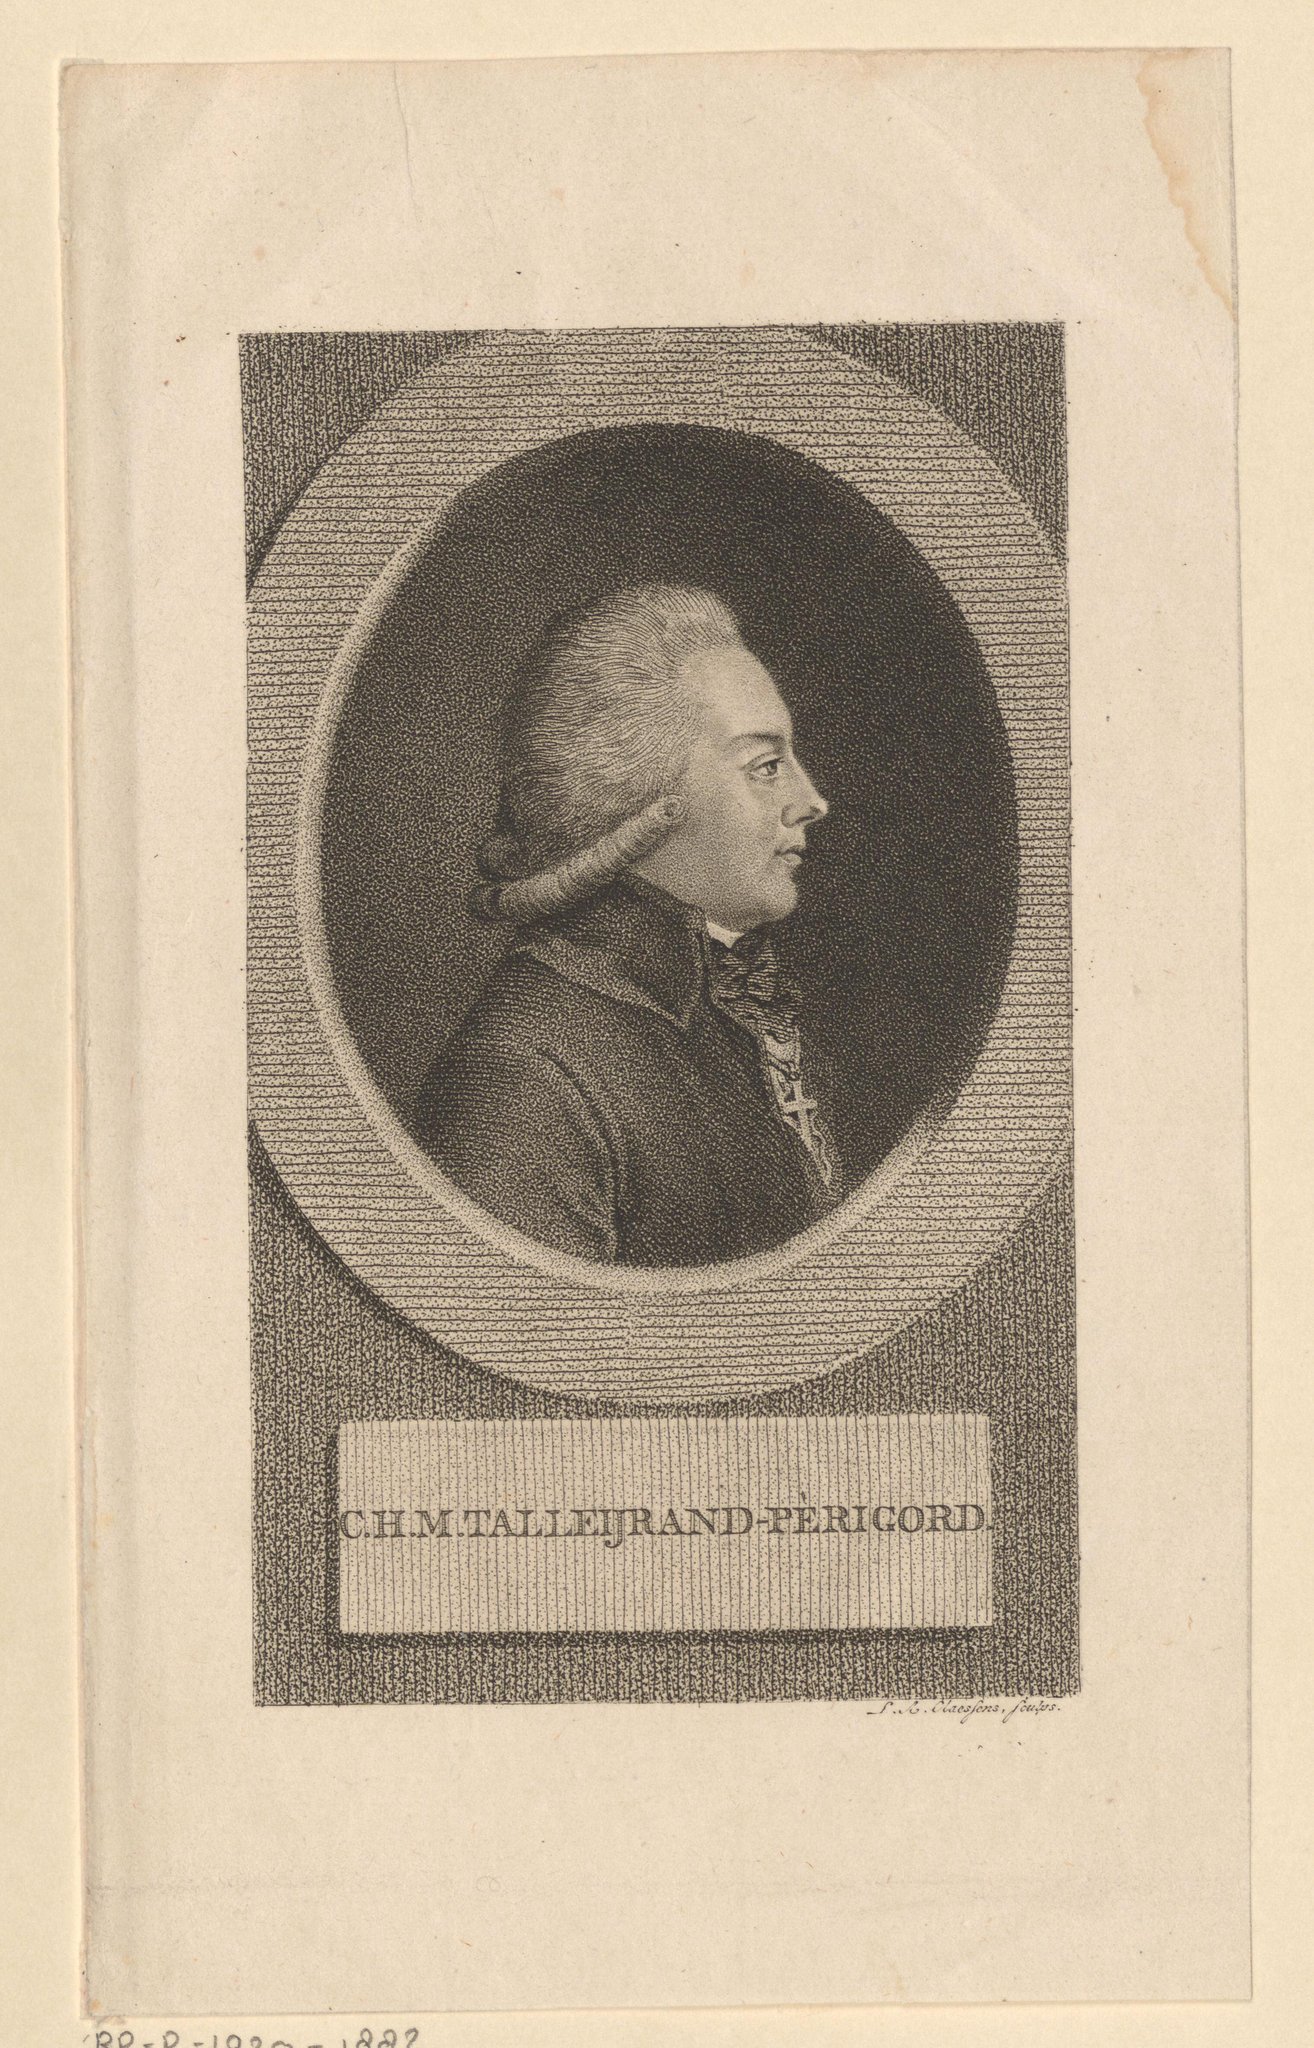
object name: print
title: Portret van Charles Maurice de Talleyrand-Périgord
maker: lambertus antonius claessens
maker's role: draughtsman, print maker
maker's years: 1763-1834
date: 1789-1843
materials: paper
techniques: etching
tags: paris, politician, charles maurice hertog van talleyrand-périgord, historical persons, politician, e.g. party leader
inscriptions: collector's mark: Lugt 2228